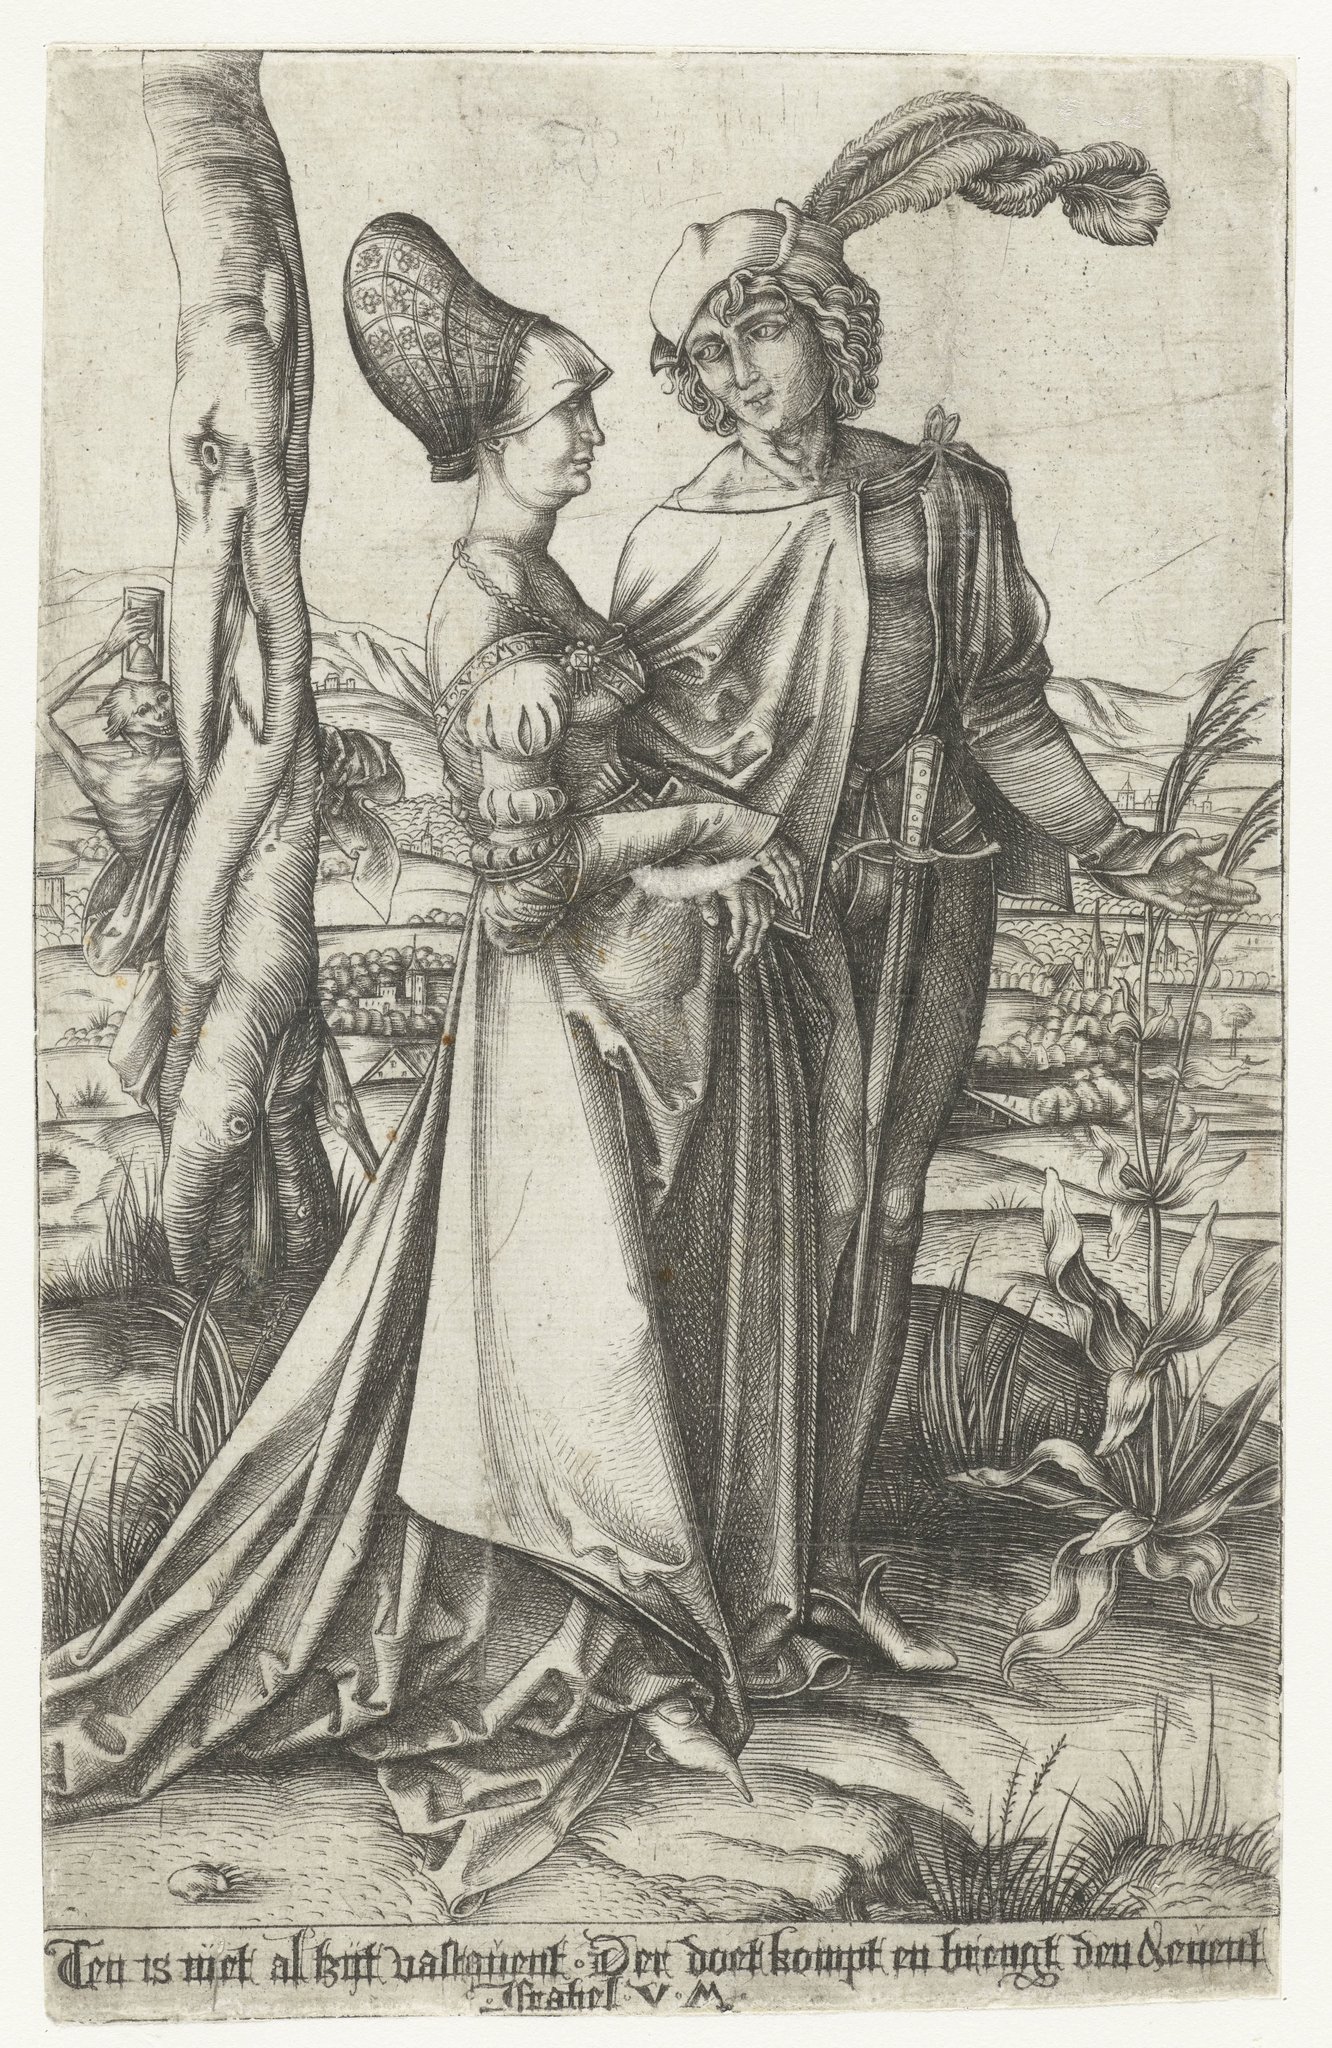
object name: print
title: Jong paar en de Dood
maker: israhel van meckenem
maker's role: print maker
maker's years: 1440-1517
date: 1455-1503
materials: paper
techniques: engraving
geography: bocholt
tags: (personifications of) 'vanitas', the vanity of human life; fragilità humana, fugacità delle grandezze & della gloria mondana, meditatione della morte, opera vana, piacere vano, vana gloria, vanità (ripa), head-gear (bonnet) (+ men's clothes), head-gear (bonnet) (+ feathers used for clothes), cape (+ men's clothes), death as skeleton, clothes, costume (+ women's clothes), dress, gown (+ women's clothes), clothes, costume (+ men's clothes), couple of lovers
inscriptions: inscription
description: Een jonge man en een jonge vrouw lopen in een heuvelachtig landschap. Vanachter een boom loert de Dood (in de gedaante van een skelet met een zandloper) op hen. Onder de voorstelling een regel Nederlandse tekst in gotisch schrift: "Ten is niet al tzijt vastavent. Der doet kompt en brengt den Aevent".